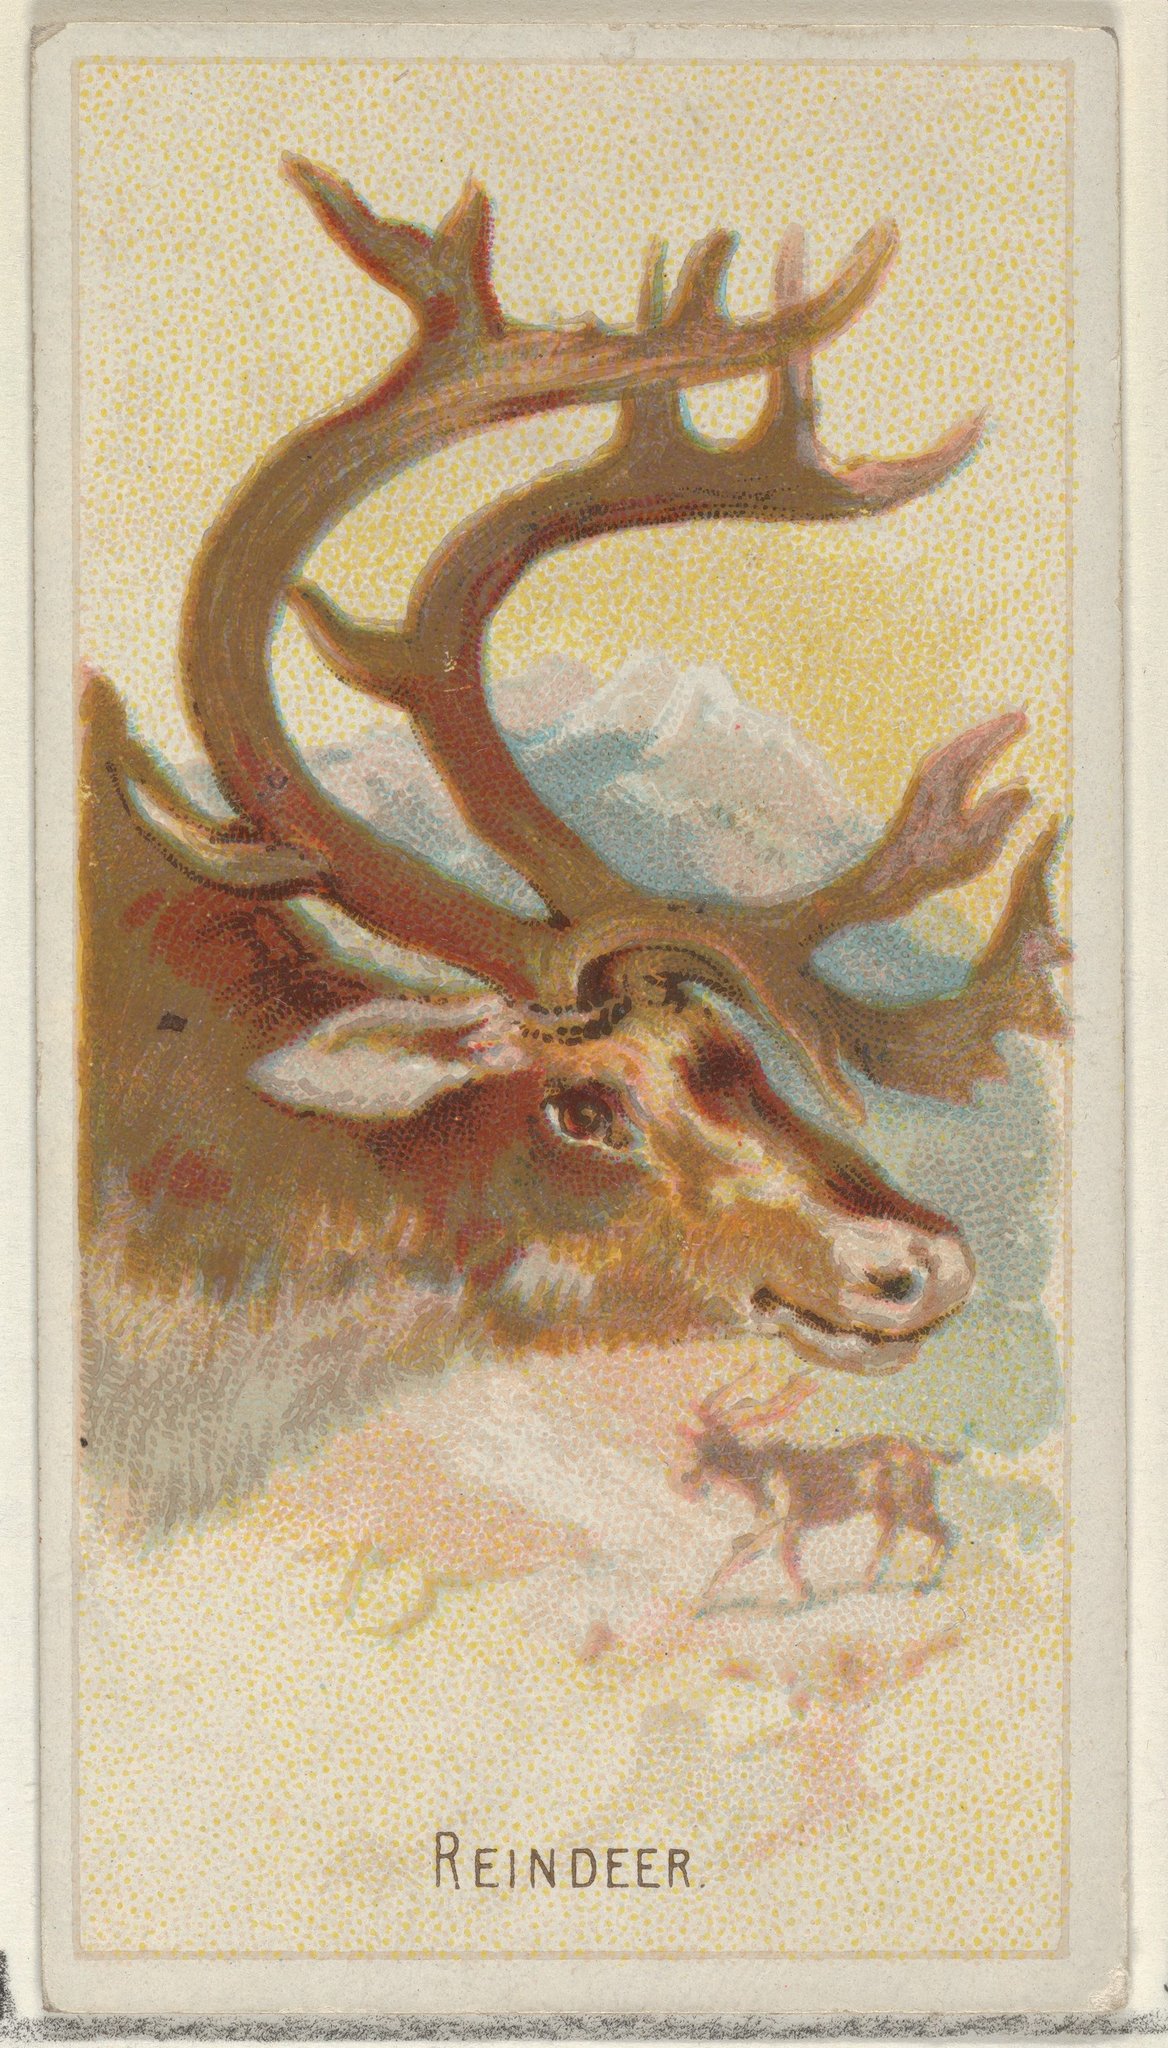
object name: print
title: Reindeer, from the Wild Animals of the World series (N25) for Allen & Ginter Cigarettes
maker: allen & ginter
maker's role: publisher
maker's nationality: american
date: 1888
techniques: color lithograph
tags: deer